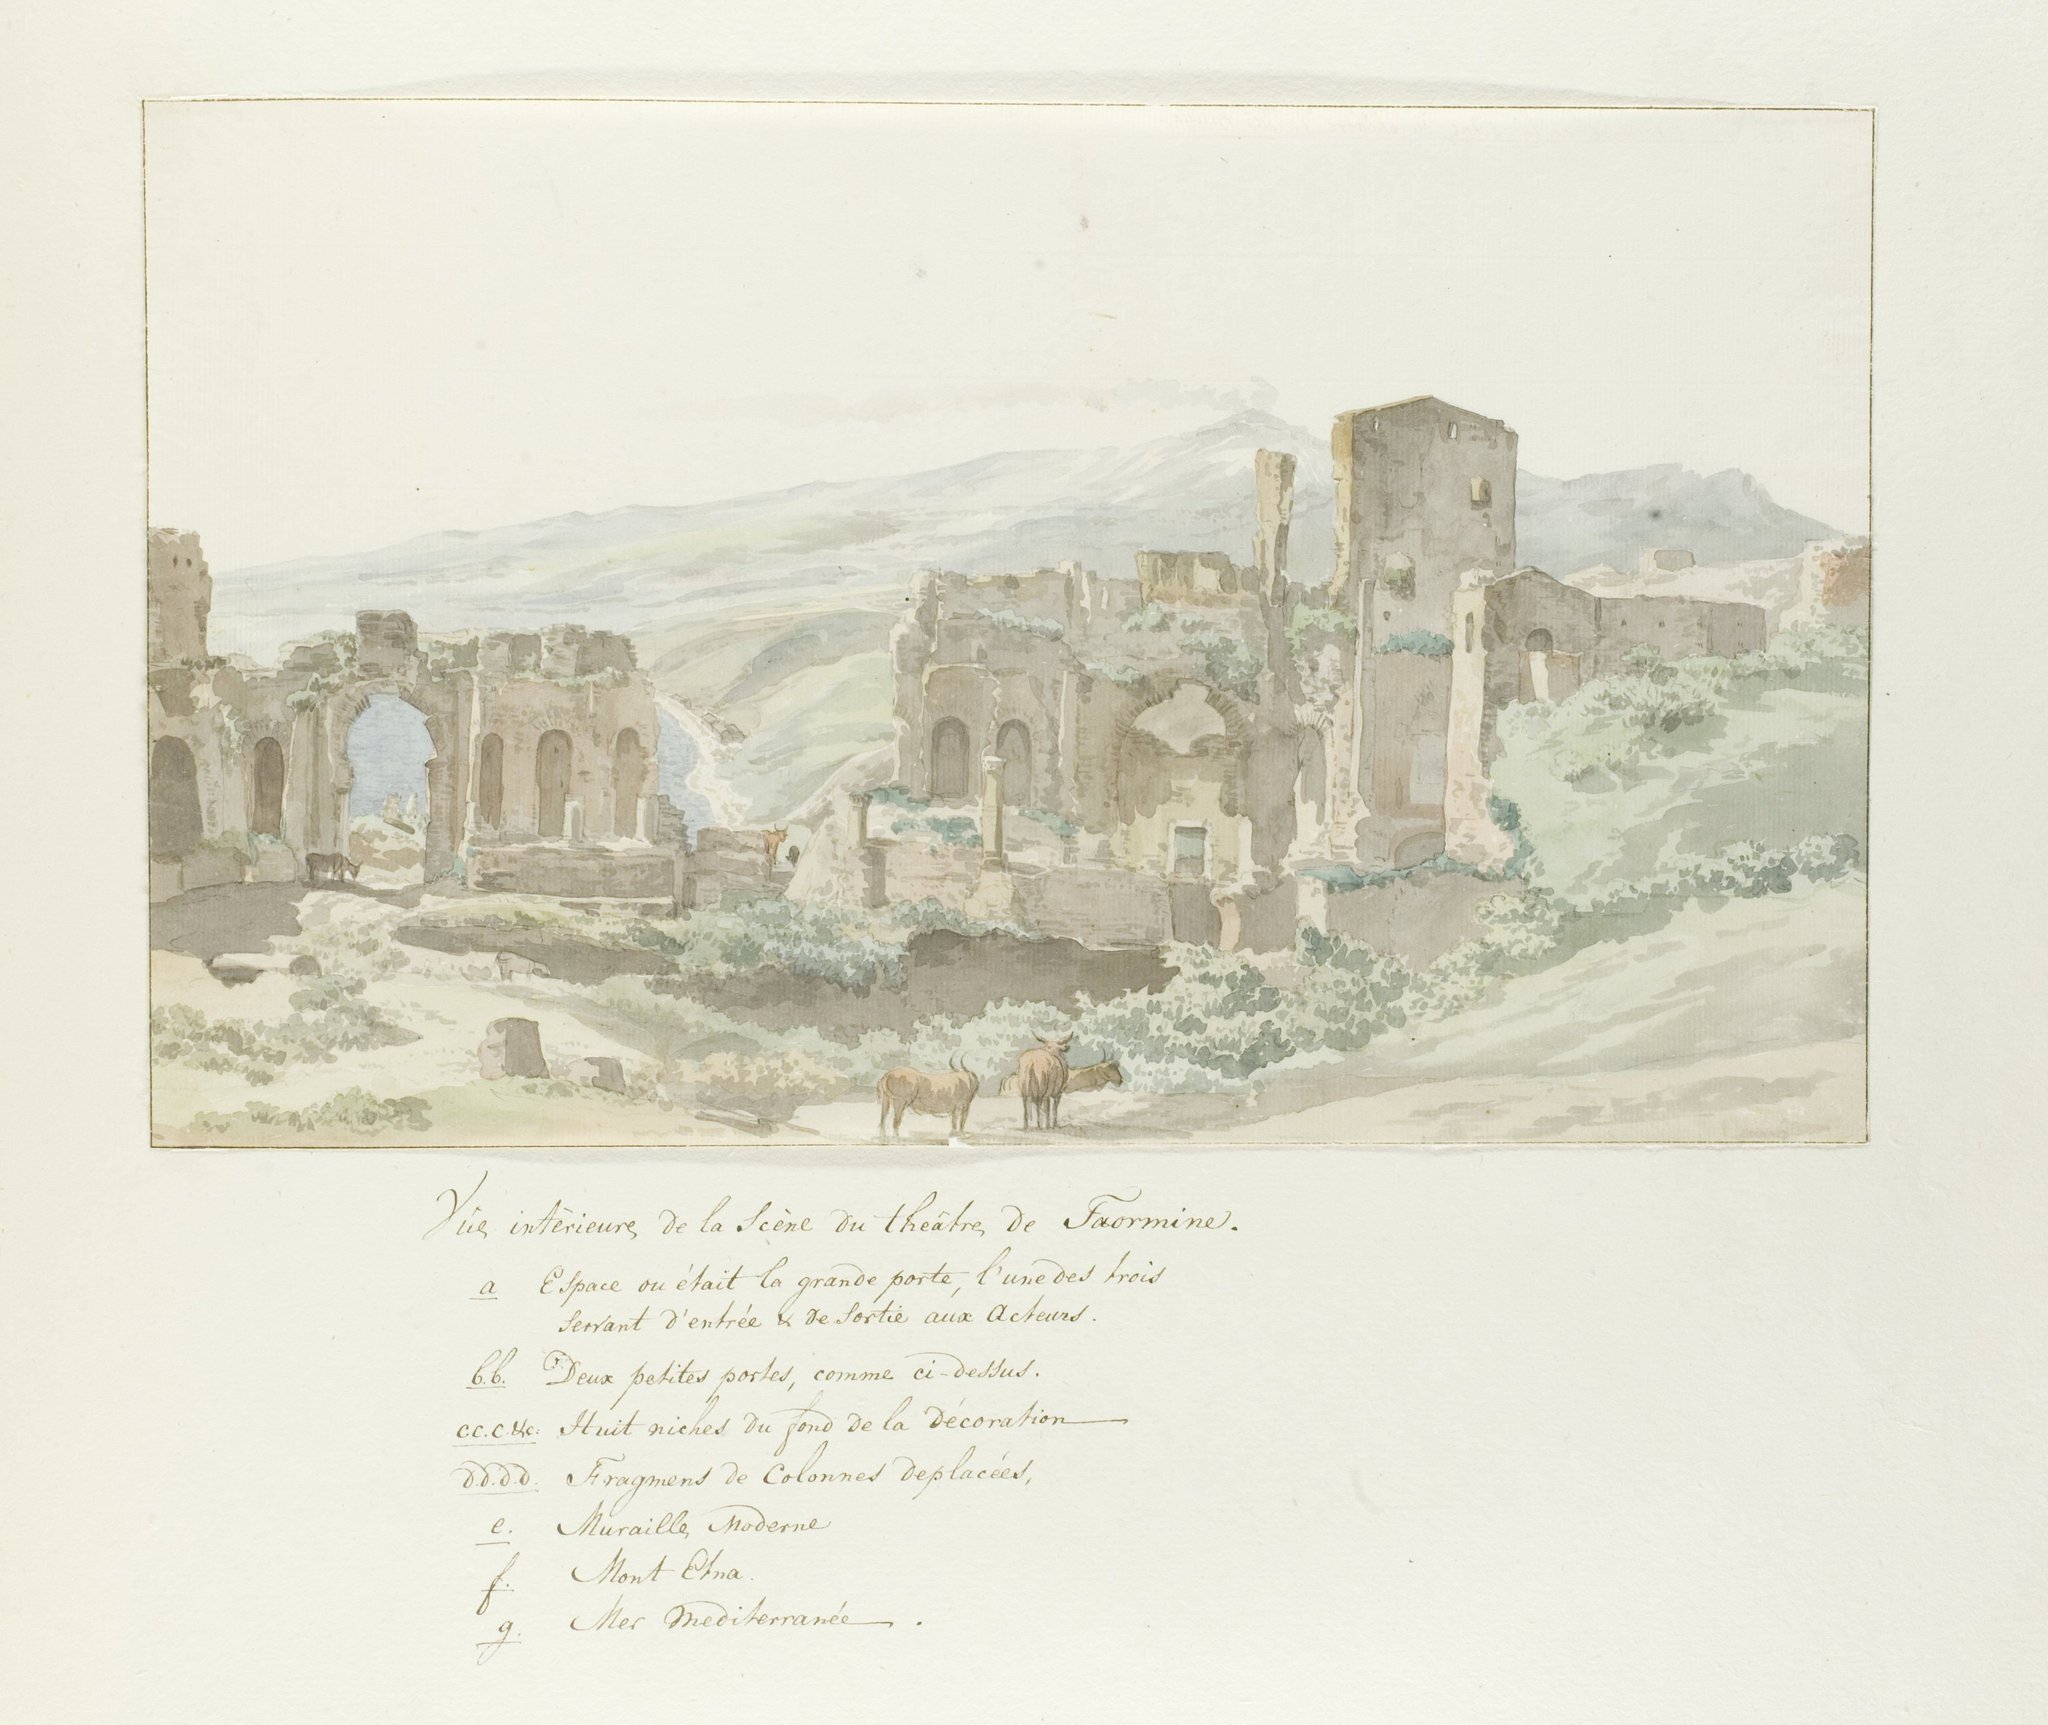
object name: watercolor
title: Vue intérieure de la Scène du Théâtre de Tavormina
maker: louis ducros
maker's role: draughtsman, print maker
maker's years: 1748-1810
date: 1778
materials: chalk, paper, watercolor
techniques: brush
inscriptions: inscription: ‘No 153 [bis] Vue intérieure de la Scène du Théâtre de Tavormina’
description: Tekening uit het album 'Voyage en Italie, en Sicile et à Malte', 1778.